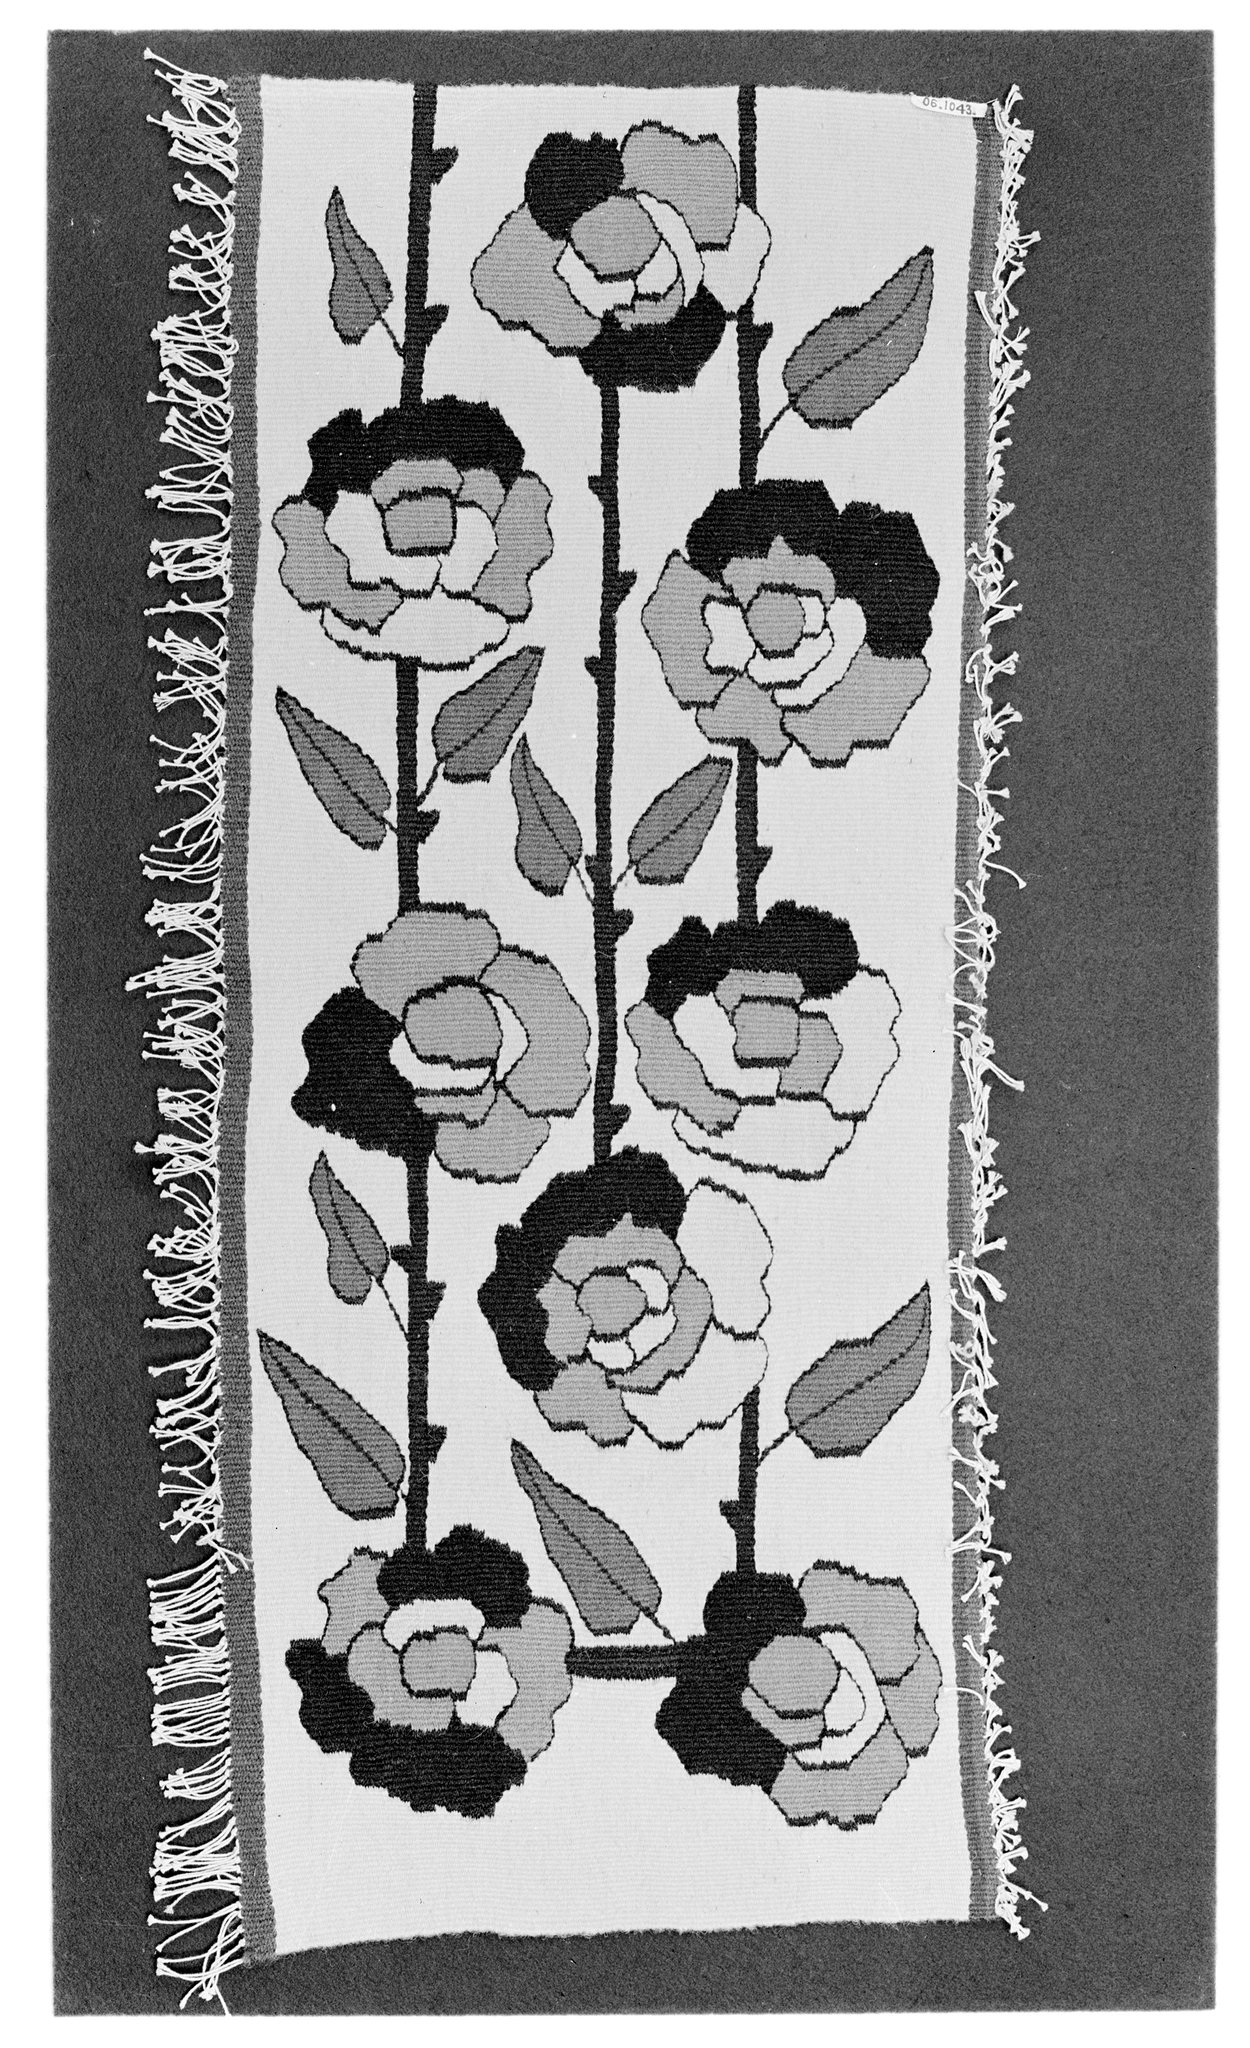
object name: cover or hanging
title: Roses against a green ground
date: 1801-1900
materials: cotton, wool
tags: roses